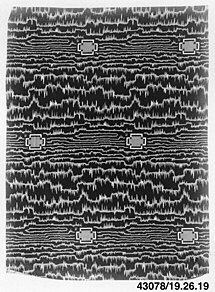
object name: sample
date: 1840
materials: cotton